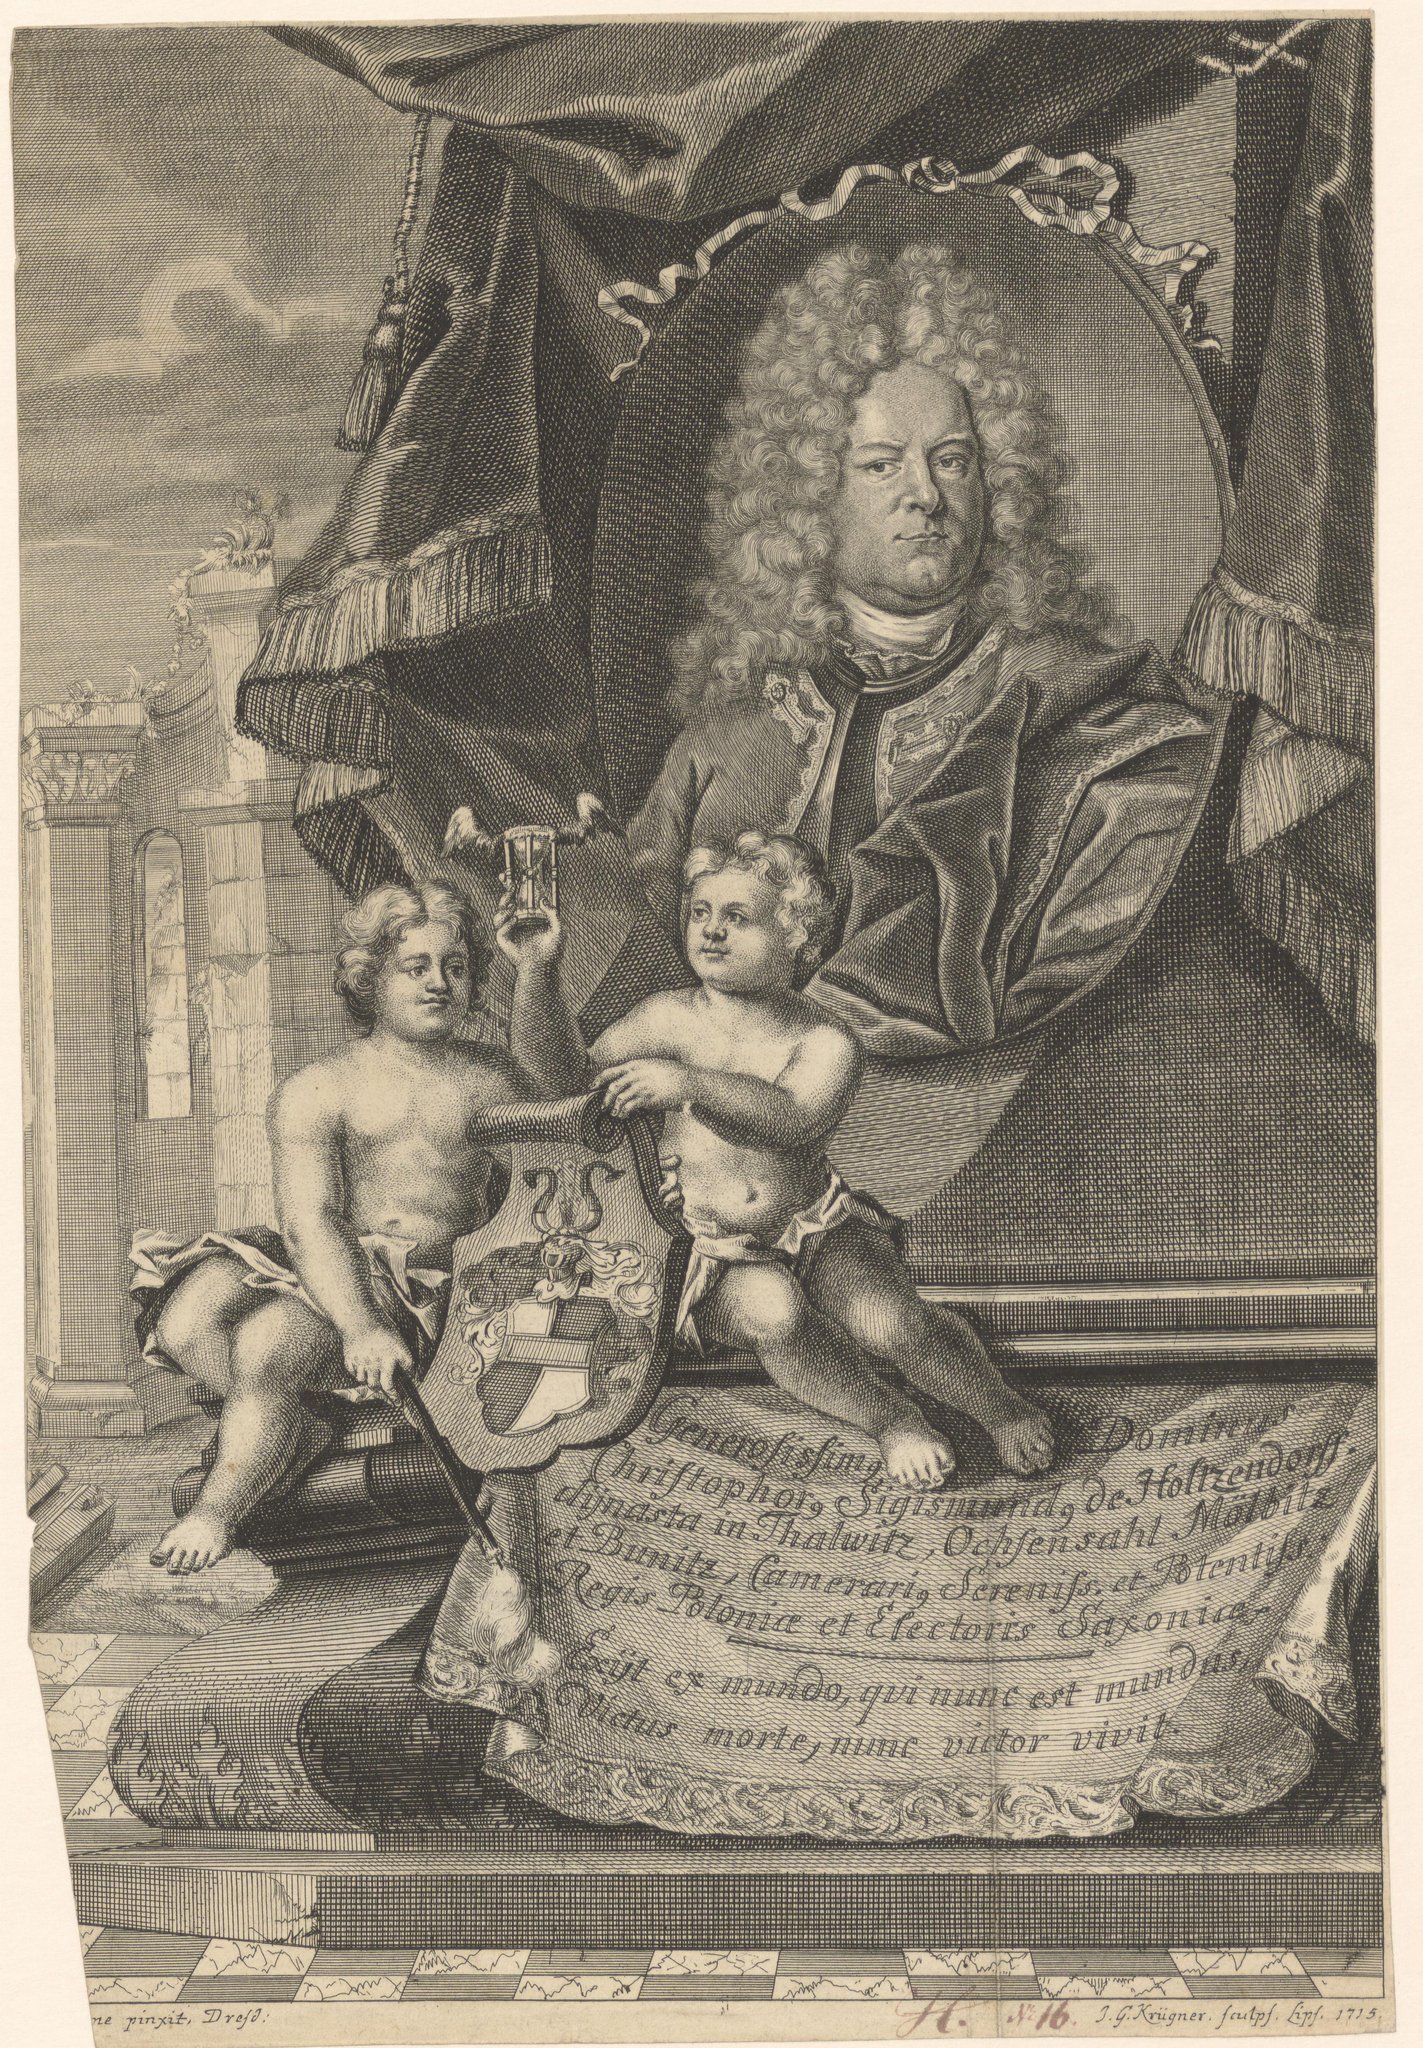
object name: print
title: Portret van Christoph Sigmund von Holtzendorff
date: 1715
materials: paper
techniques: engraving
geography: dresden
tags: historical persons, 'vanitas' symbols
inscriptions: collector's mark: Lugt 358, collector's mark: Lugt 2228